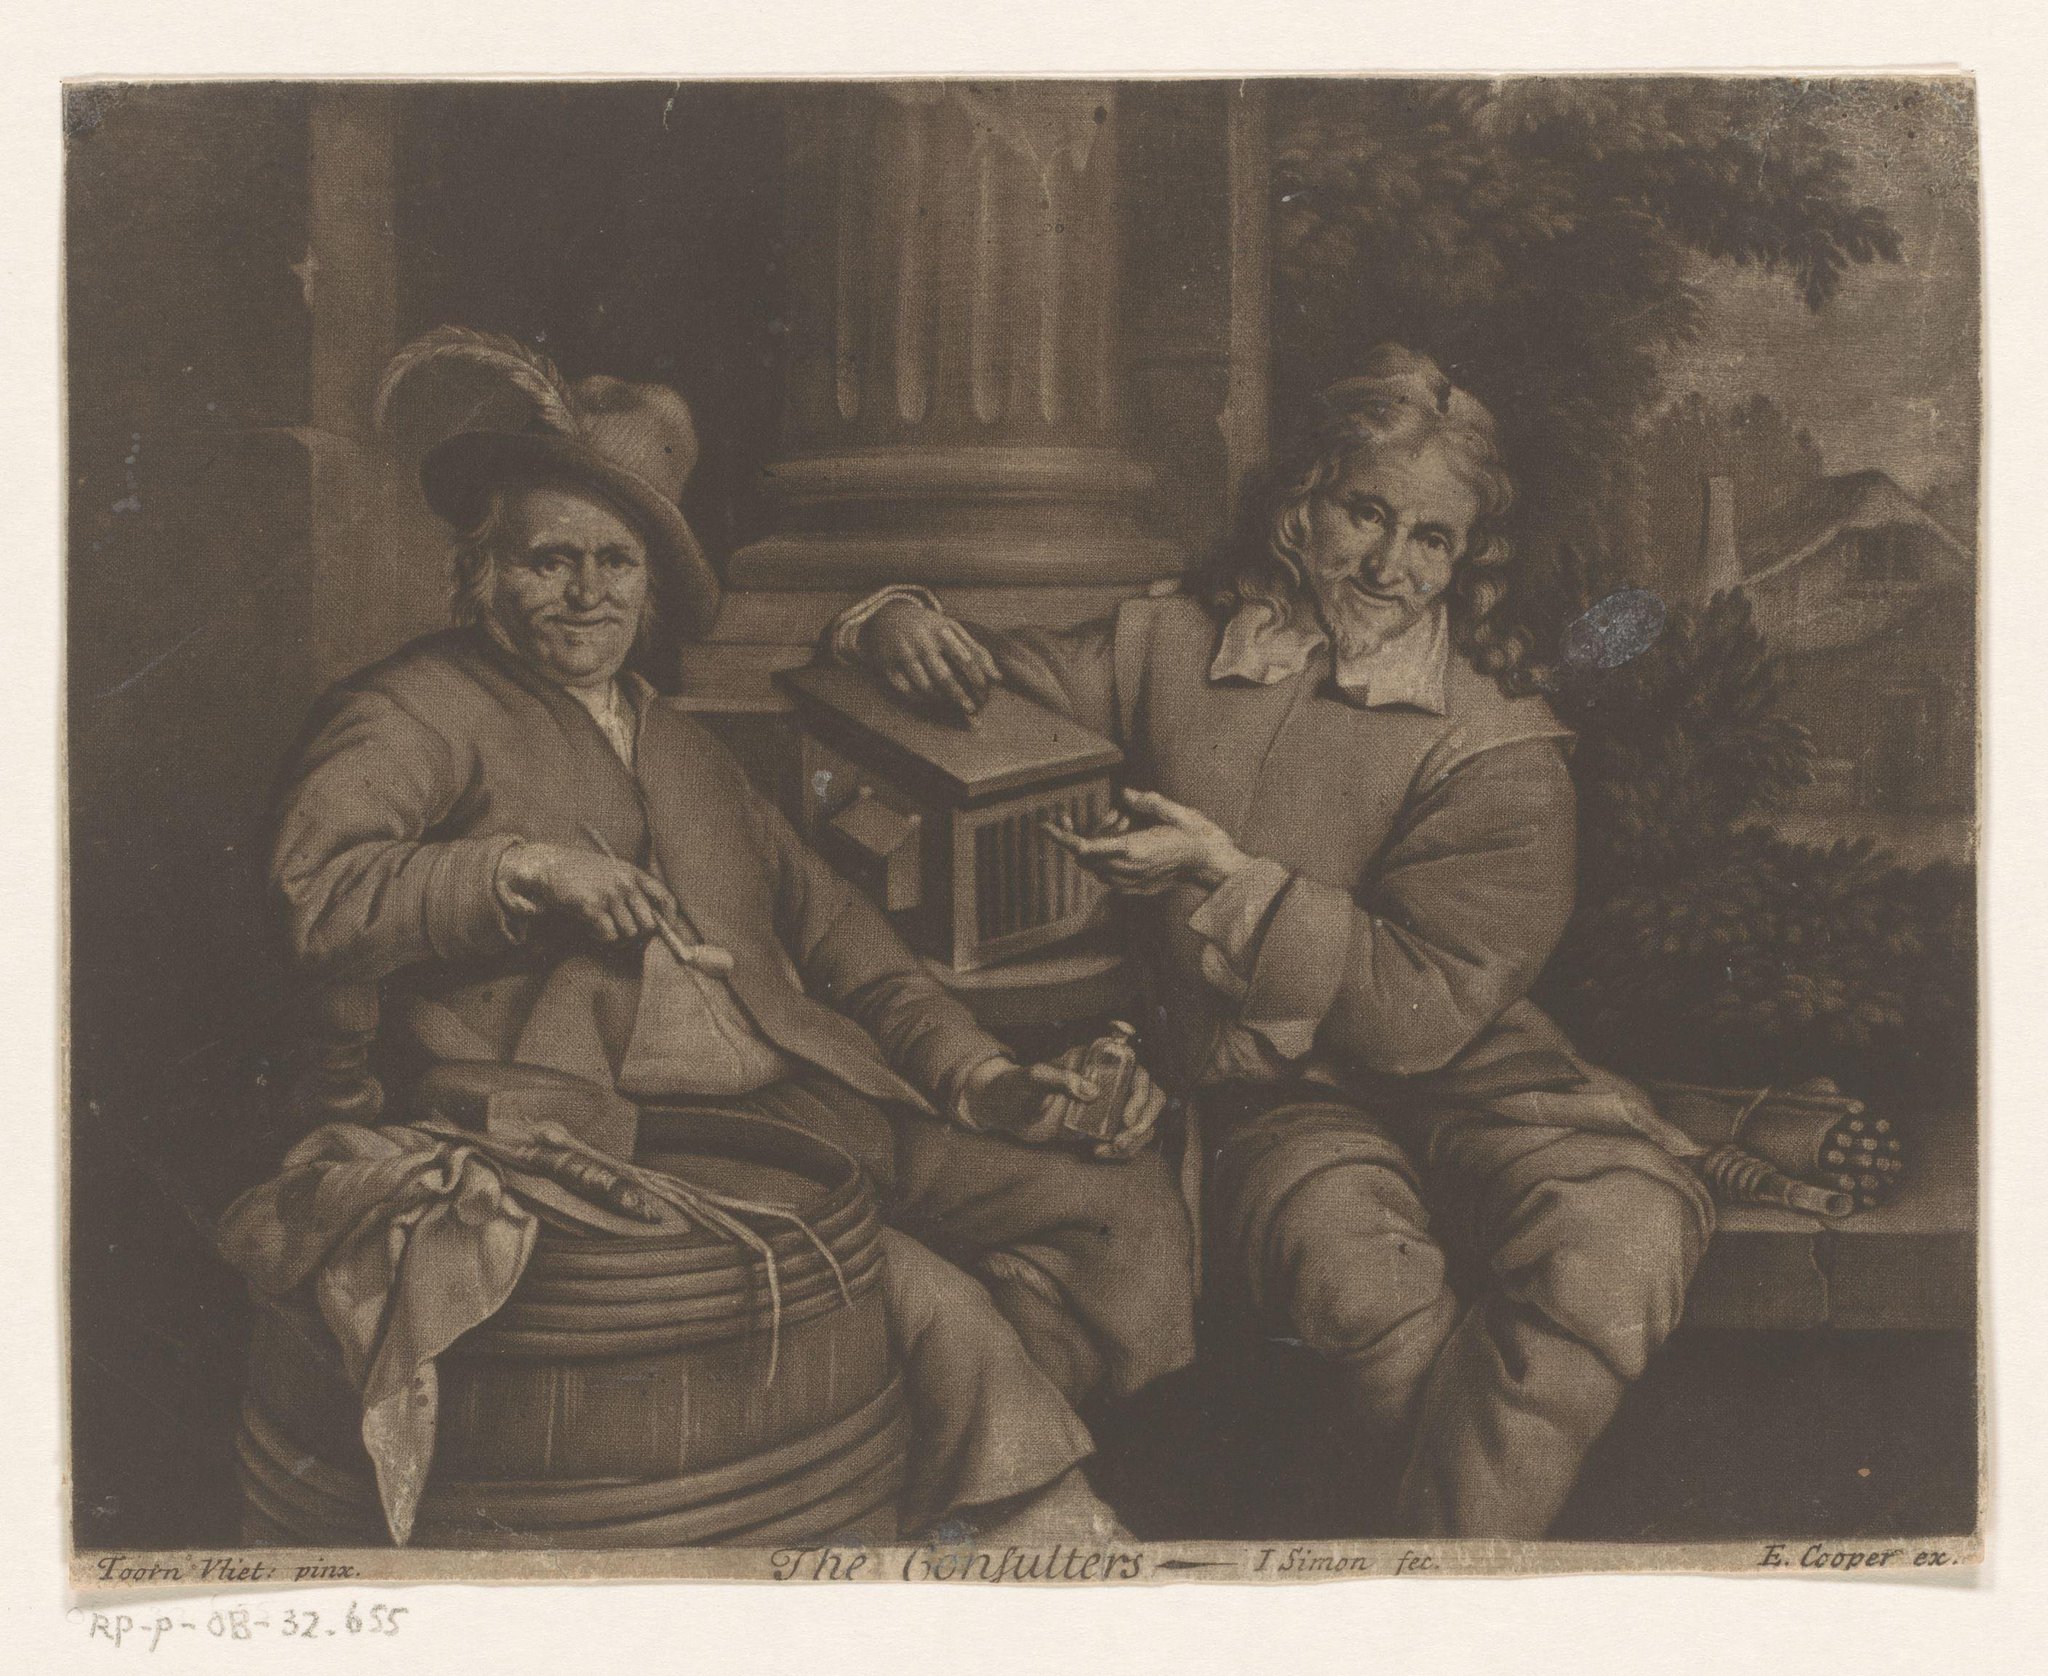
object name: print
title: The Consulters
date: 1685-1751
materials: paper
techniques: mezzotint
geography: london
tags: merchant, salesman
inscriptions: collector's mark: Lugt 240